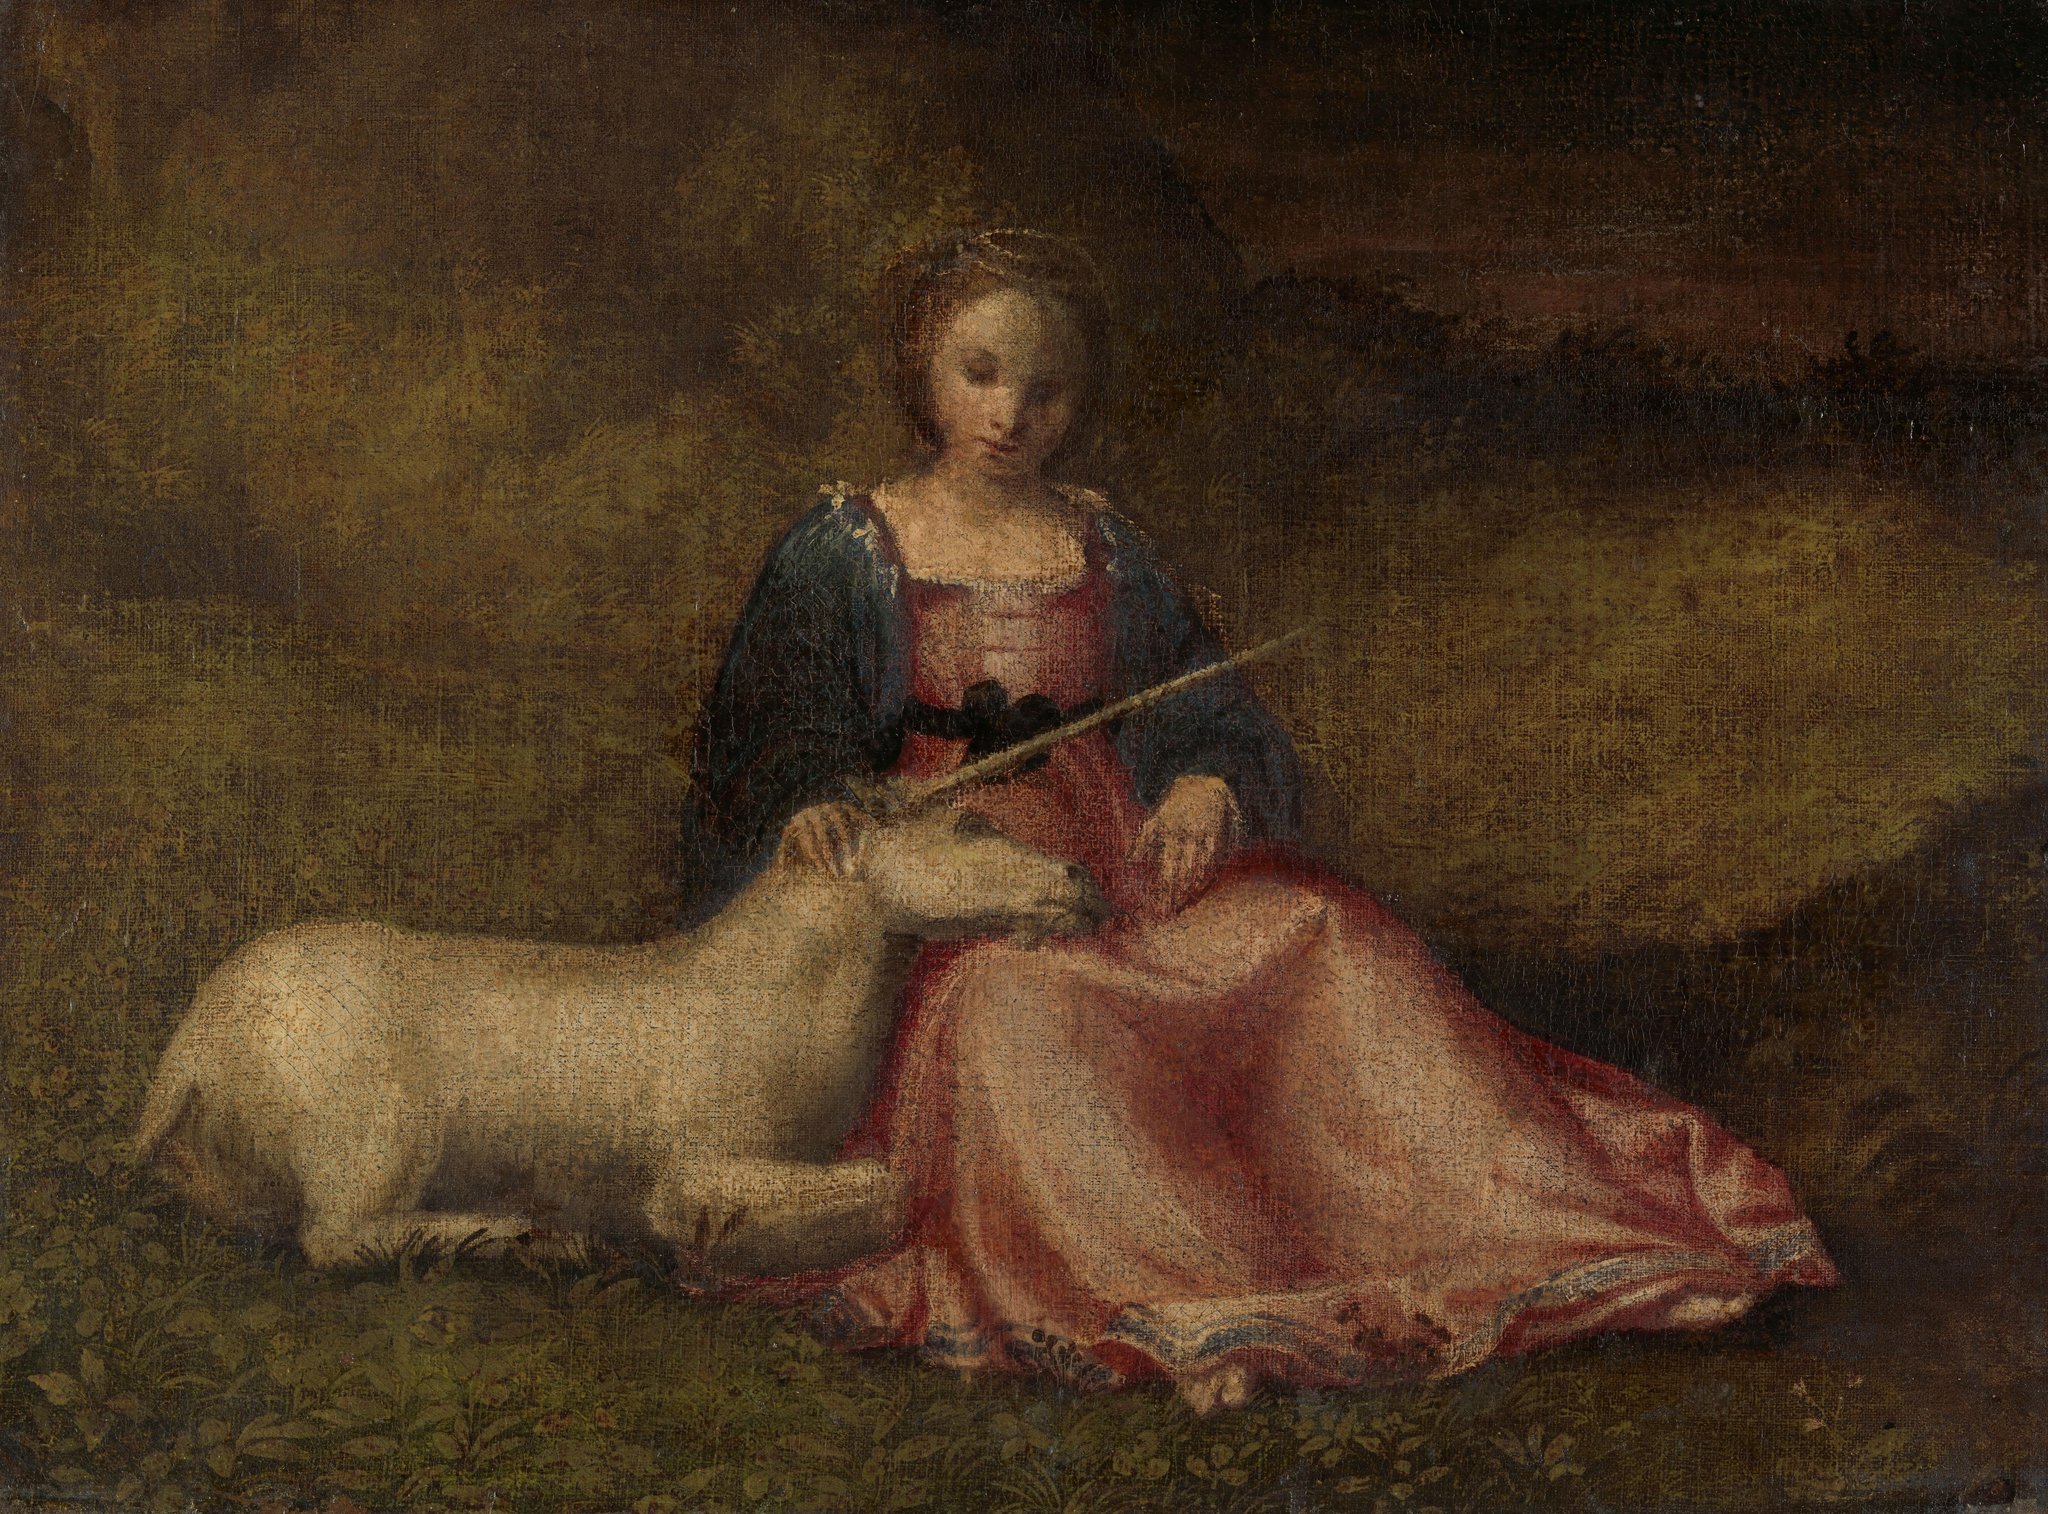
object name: painting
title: "Woman with Unicorn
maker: Anonymous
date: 1510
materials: canvas, oil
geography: venice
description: In een landschap zit een jonge vrouw met een eenhoorn die zijn kop in haar schoot legt. Vroeger geïnterpreteerd als de heilige Justine, als personificatie van de kuisheid en als een allegorie op de rol van de stadstaat Venetië.